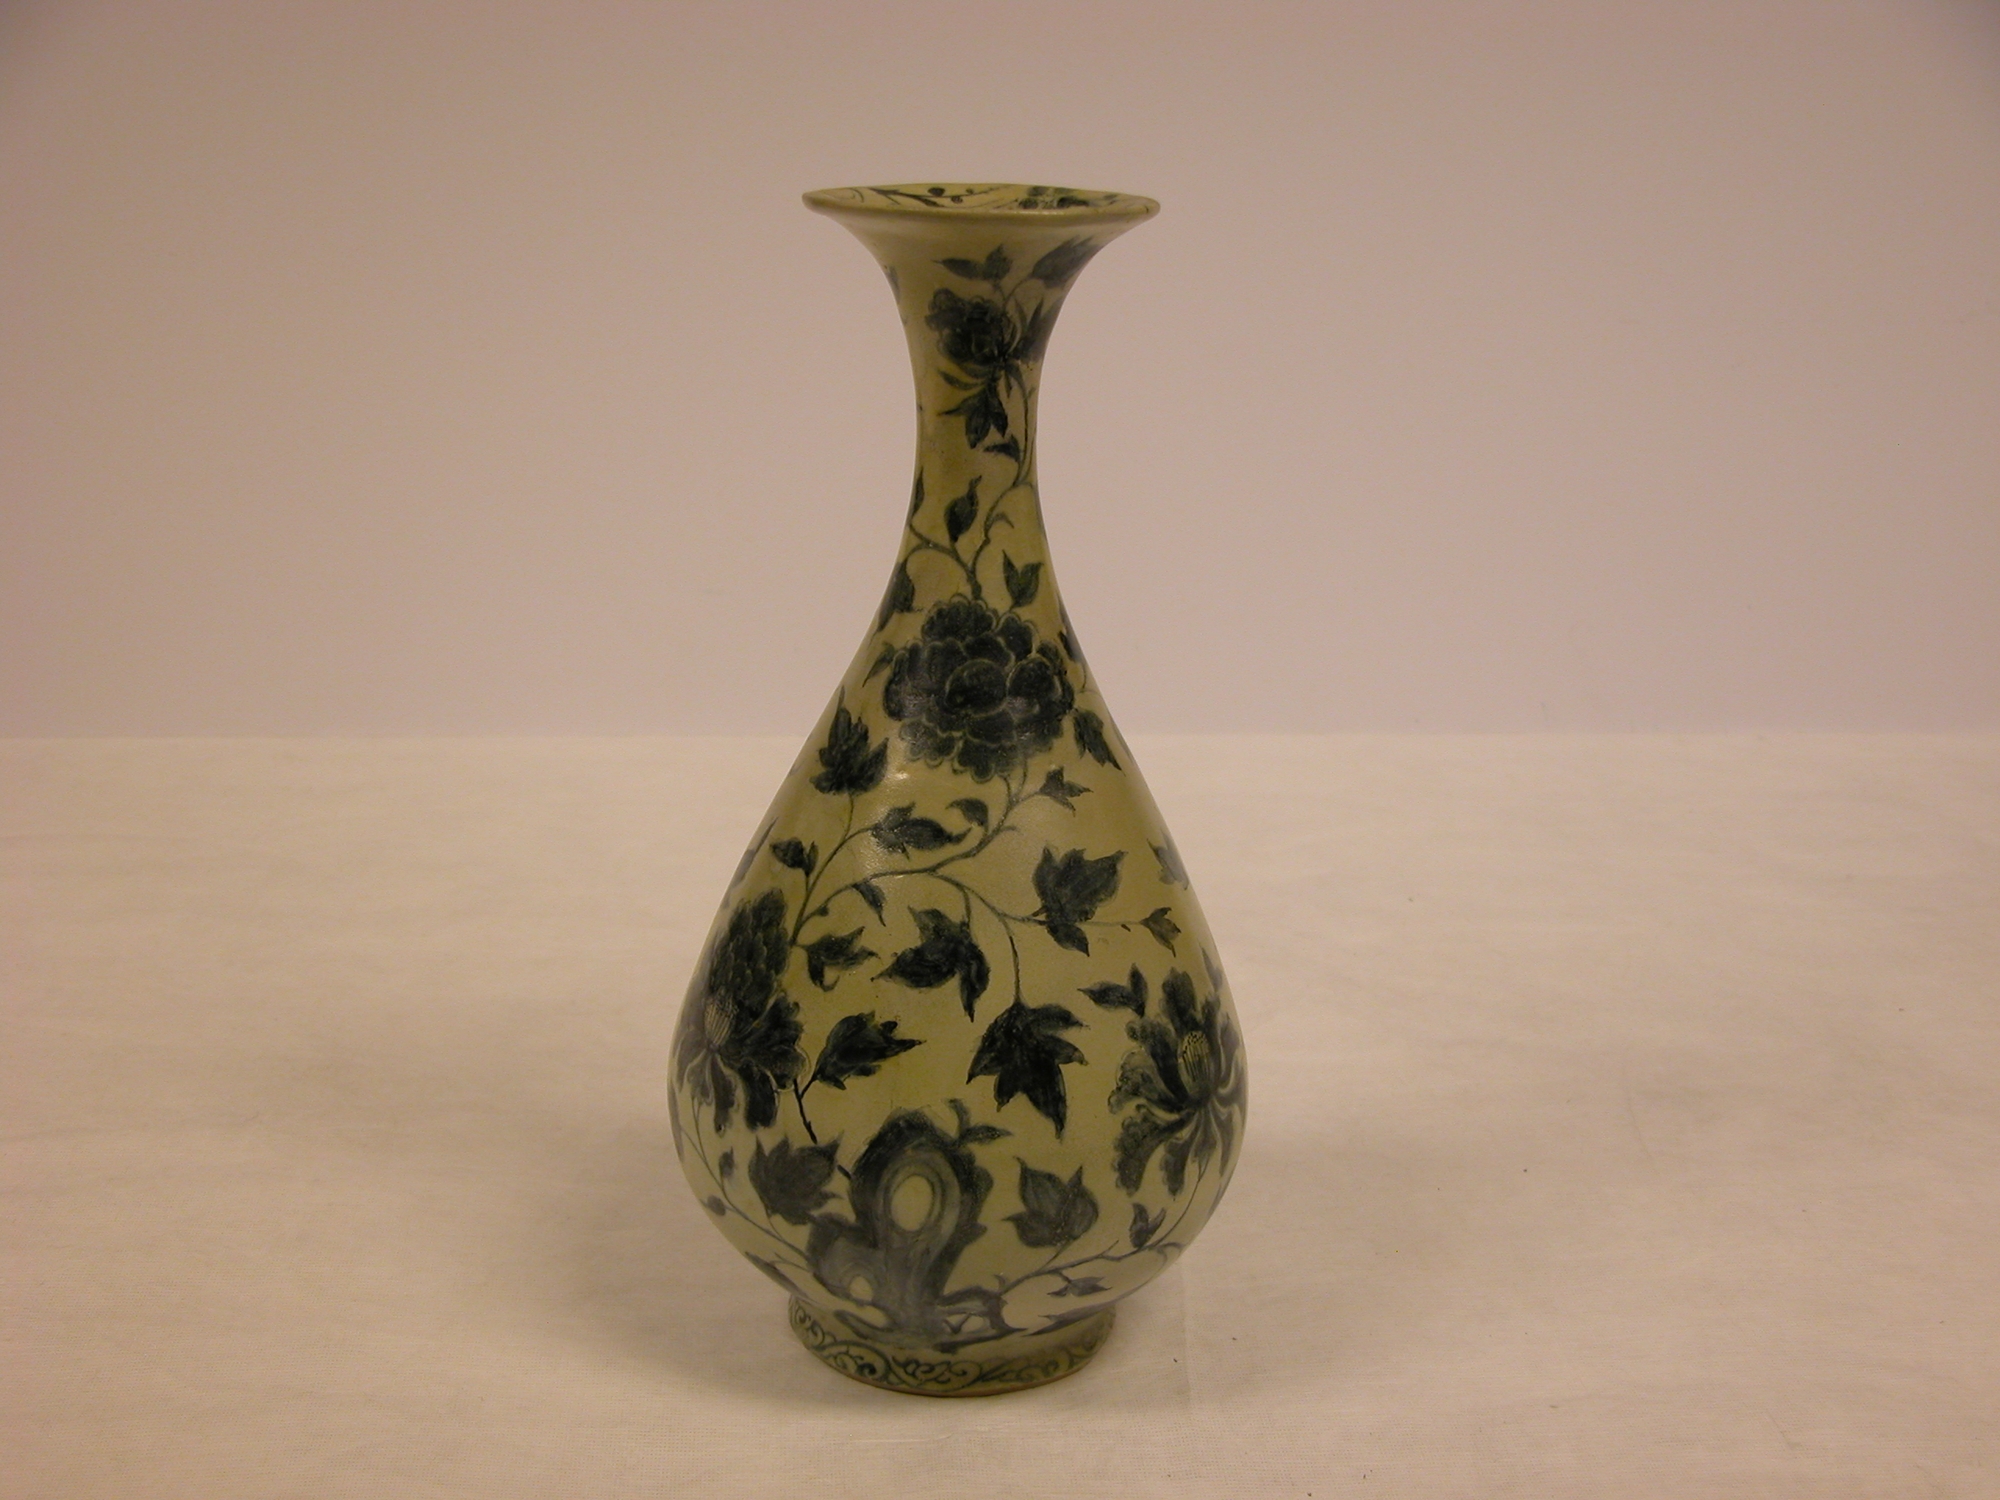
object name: bottle vase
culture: chinese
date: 1301-1400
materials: porcelain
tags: flowers,leaves